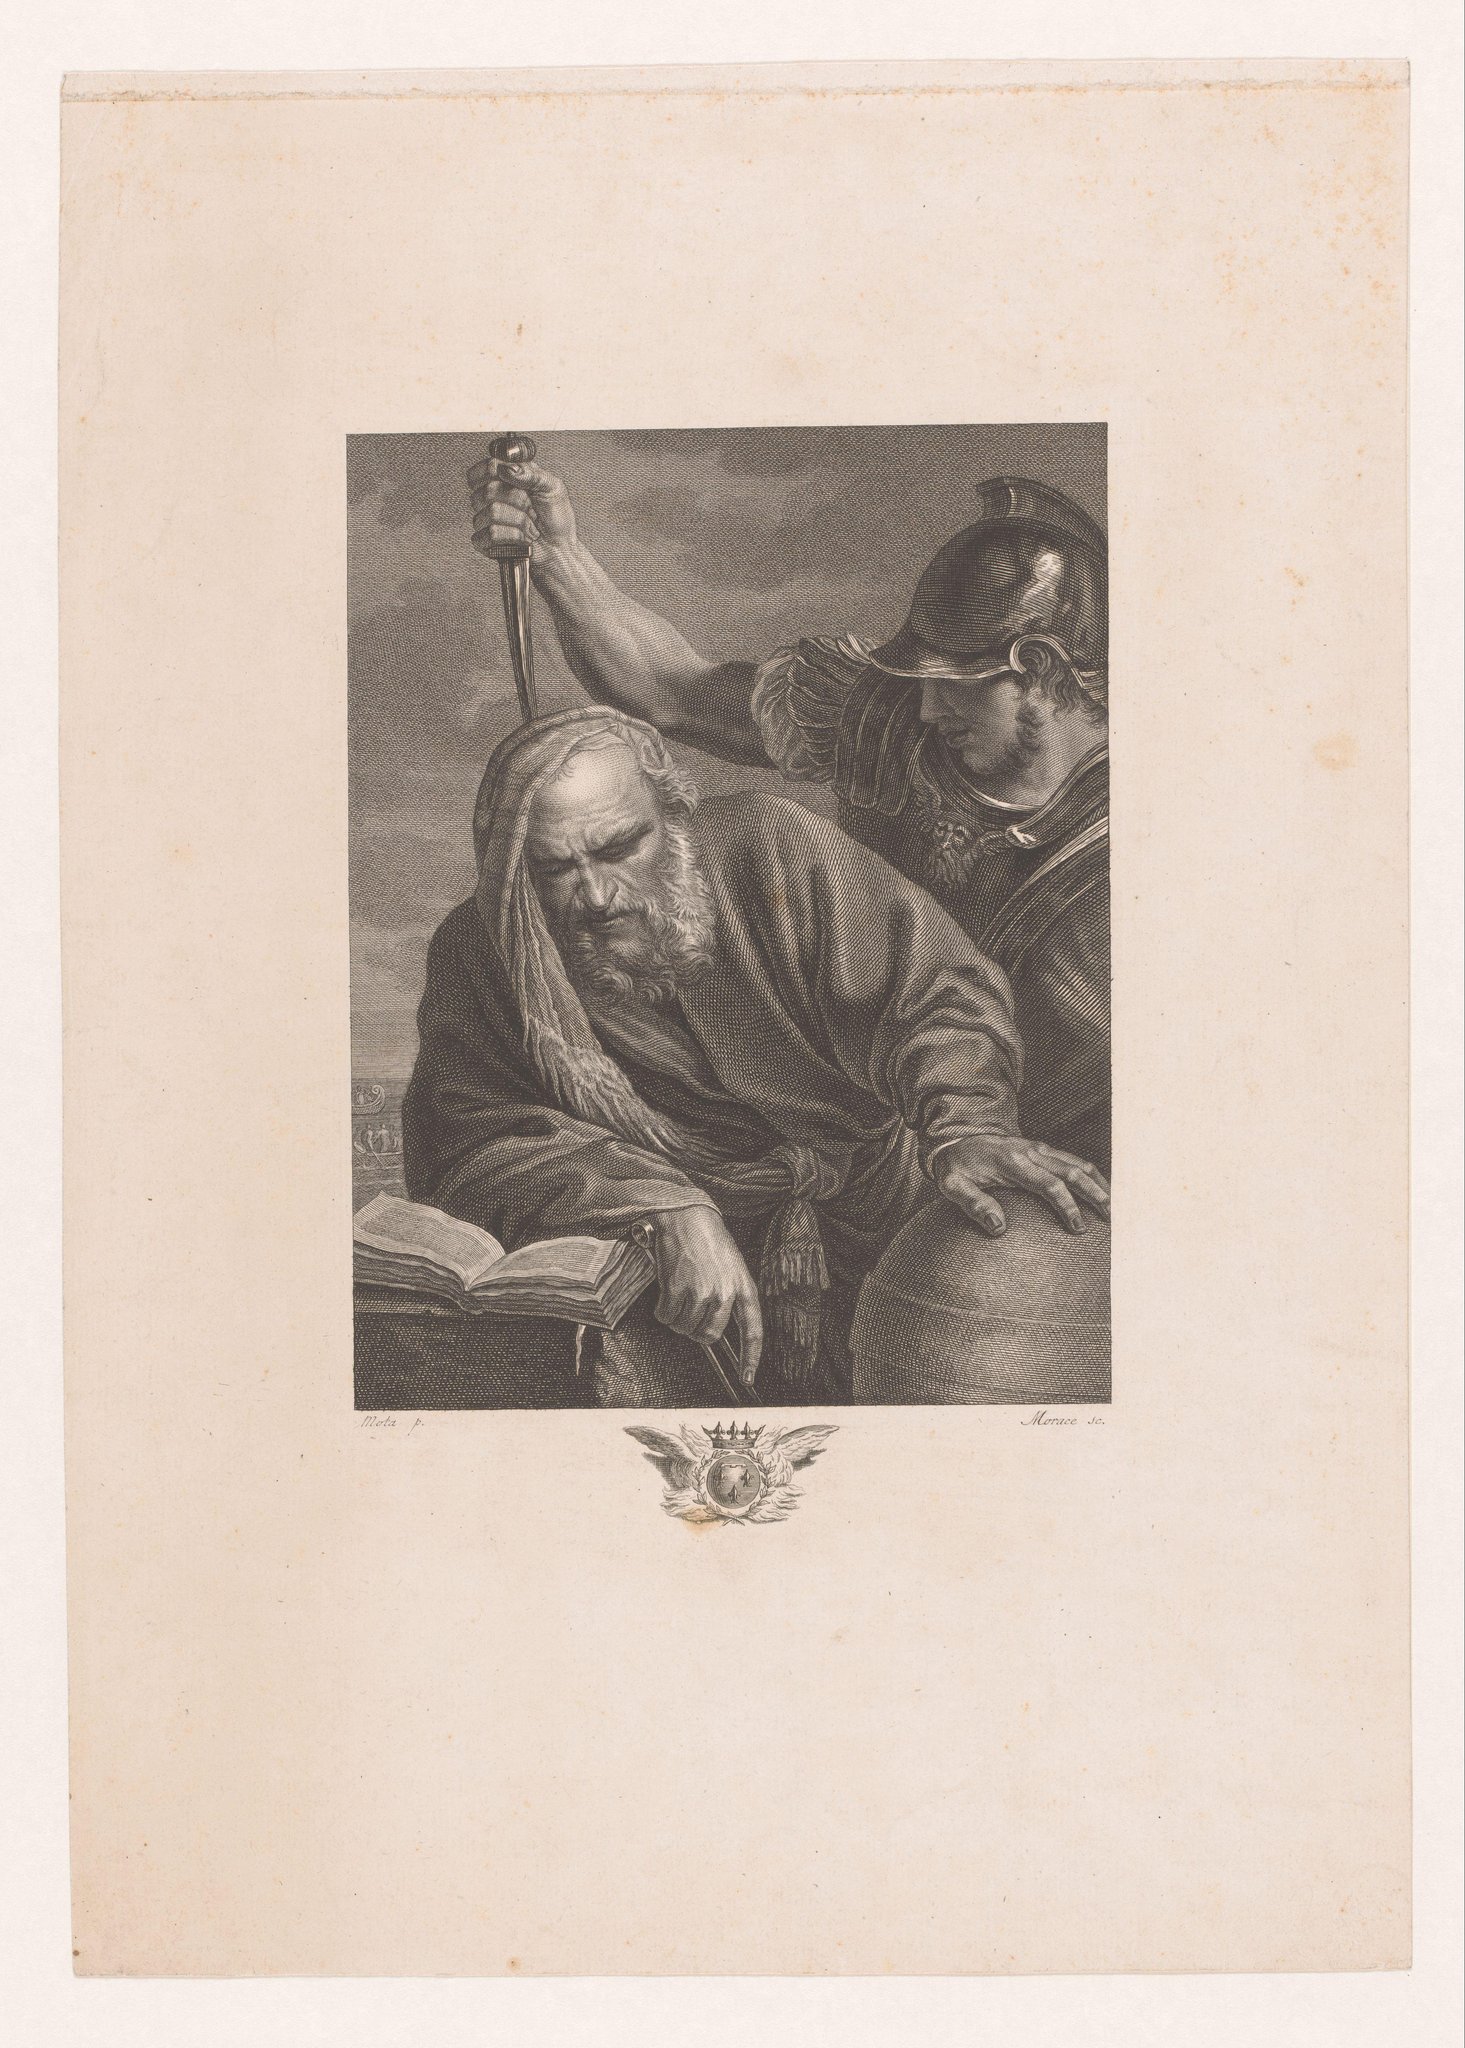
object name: print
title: Moord op Archimedes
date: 1776-1820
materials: paper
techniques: engraving, etching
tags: murder, armorial bearing, heraldry, (story of) archimedes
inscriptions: collector's mark: Lugt 2228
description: Naar een schilderij van Pier Francesco Mola uit de Galerie du Palais Royal in Parijs.